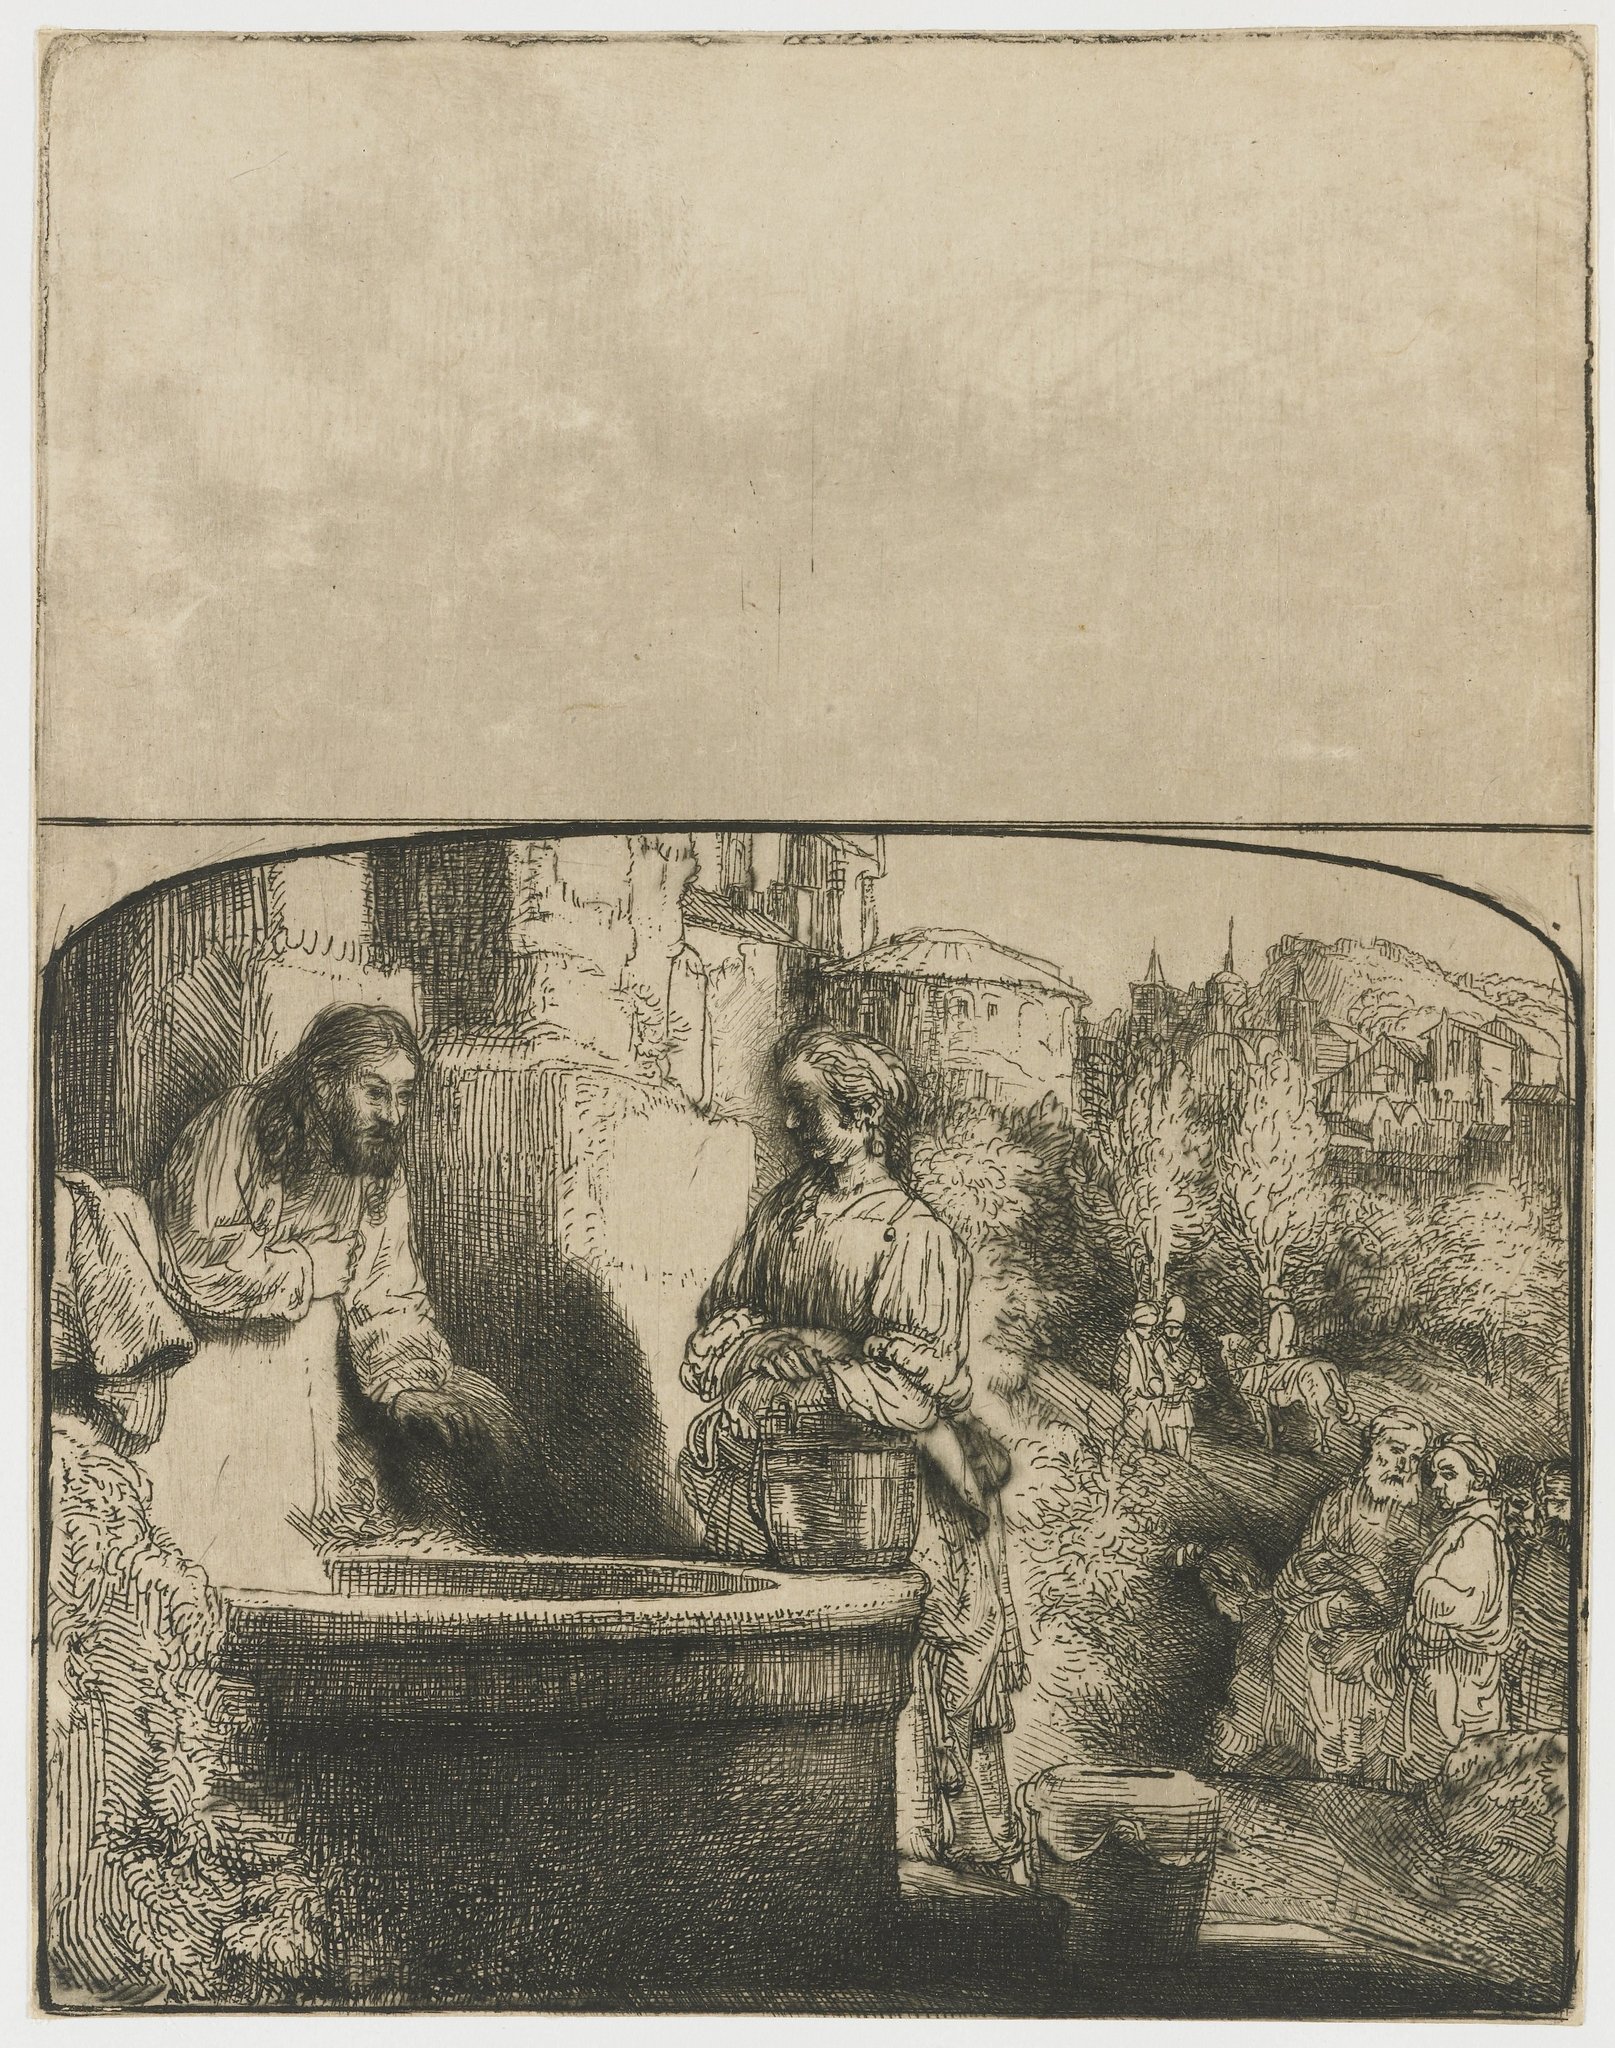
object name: print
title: Christ and the woman of Samaria: an arched print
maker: rembrandt van rijn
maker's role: draughtsman, painter, print maker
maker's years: 1606-1669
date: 1657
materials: paper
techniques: drypoint, etching, intaglio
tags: the woman of samaria (john 4:4-42)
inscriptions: signature and date: ‘Rembrandt f. 1657’, collector's mark: Lugt 240